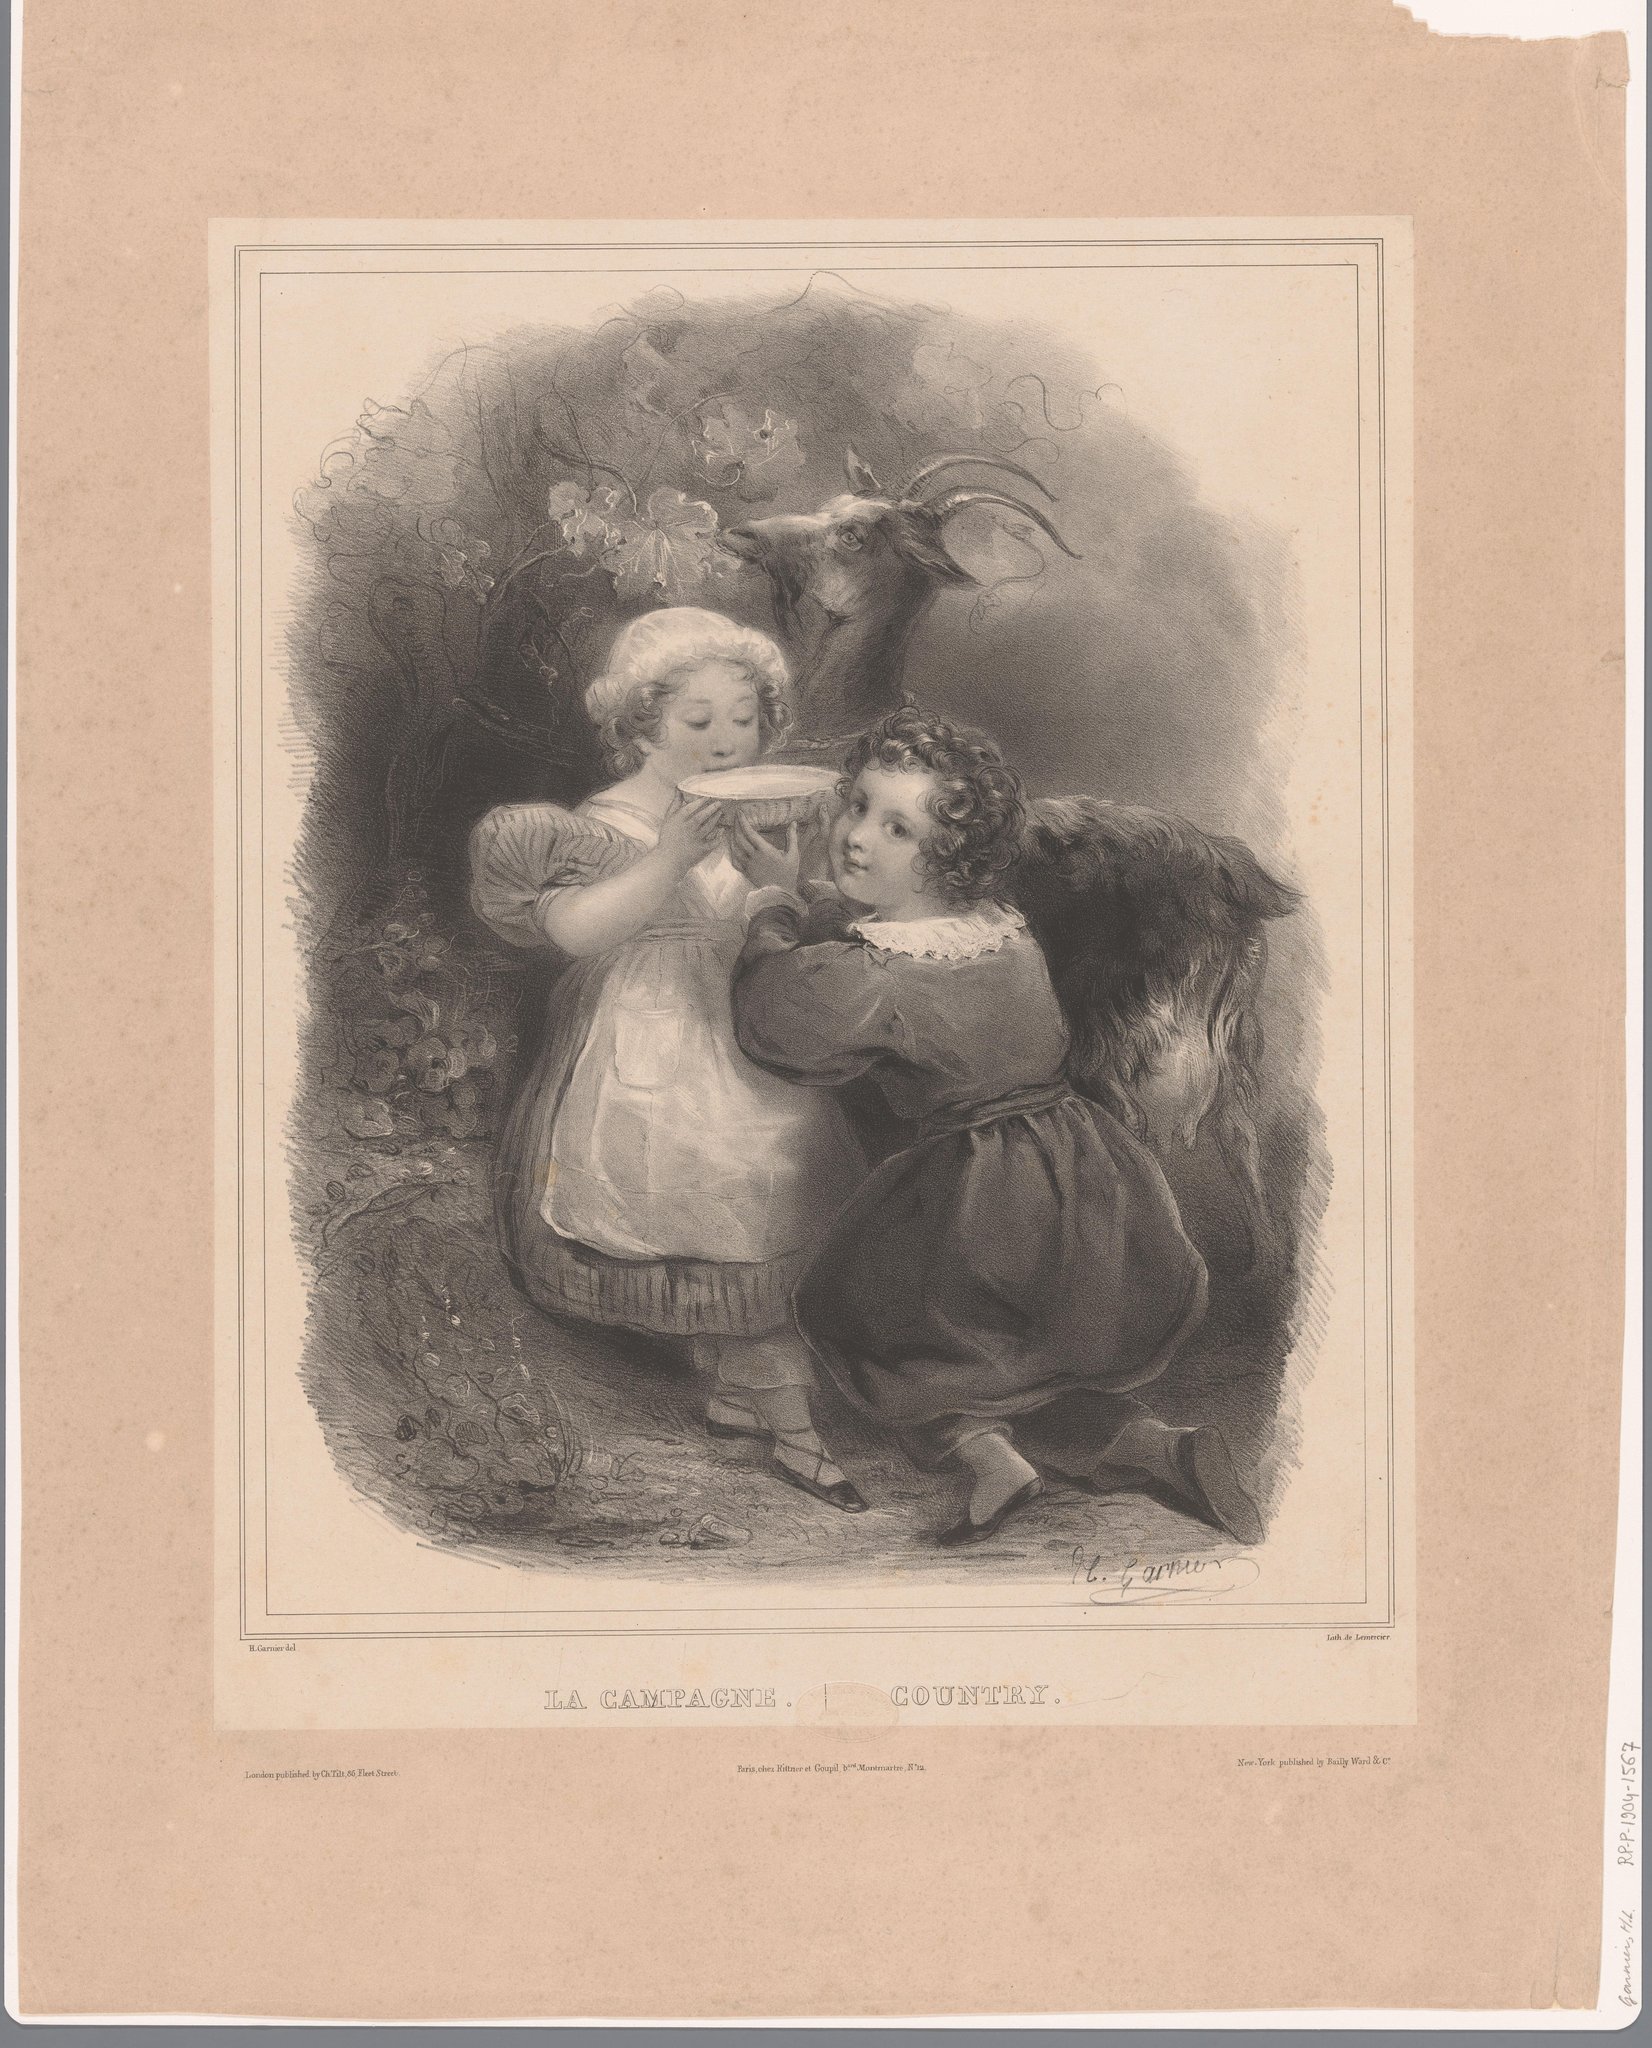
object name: print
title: La Campagne / Country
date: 1833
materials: paper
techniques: lithograph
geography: paris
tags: child playing with animals, drinking, goat, milk, rural life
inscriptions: check stamp: Lugt 2140, collector's mark: Lugt 2228a